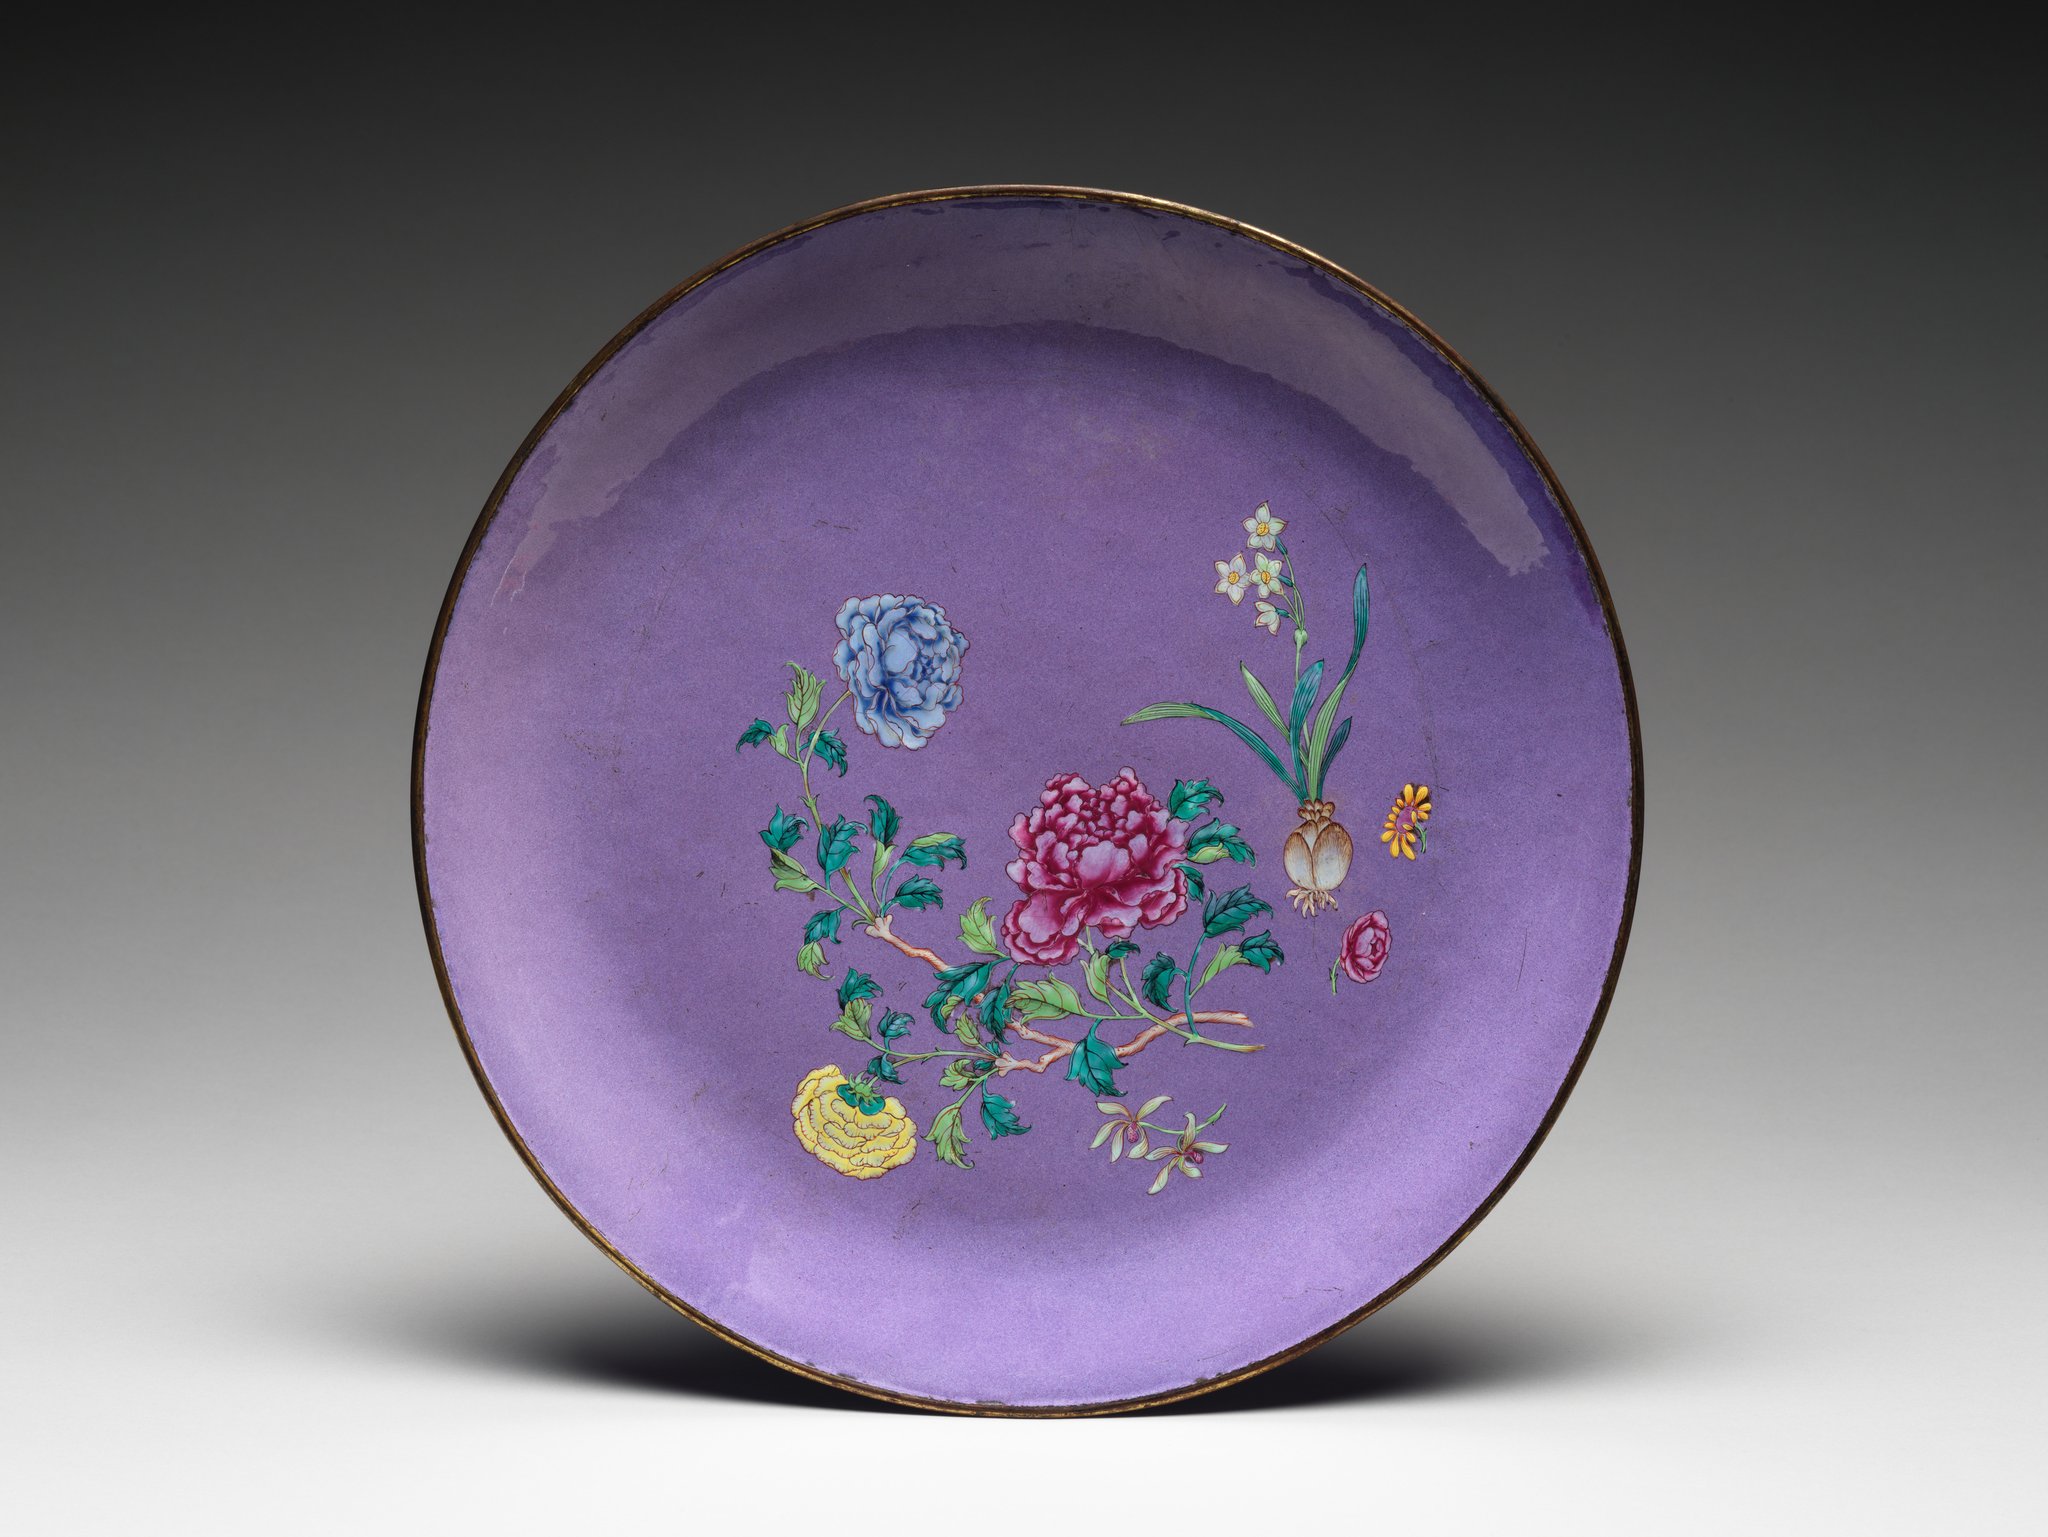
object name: dish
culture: chinese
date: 1801-1900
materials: enamel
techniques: painting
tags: flowers